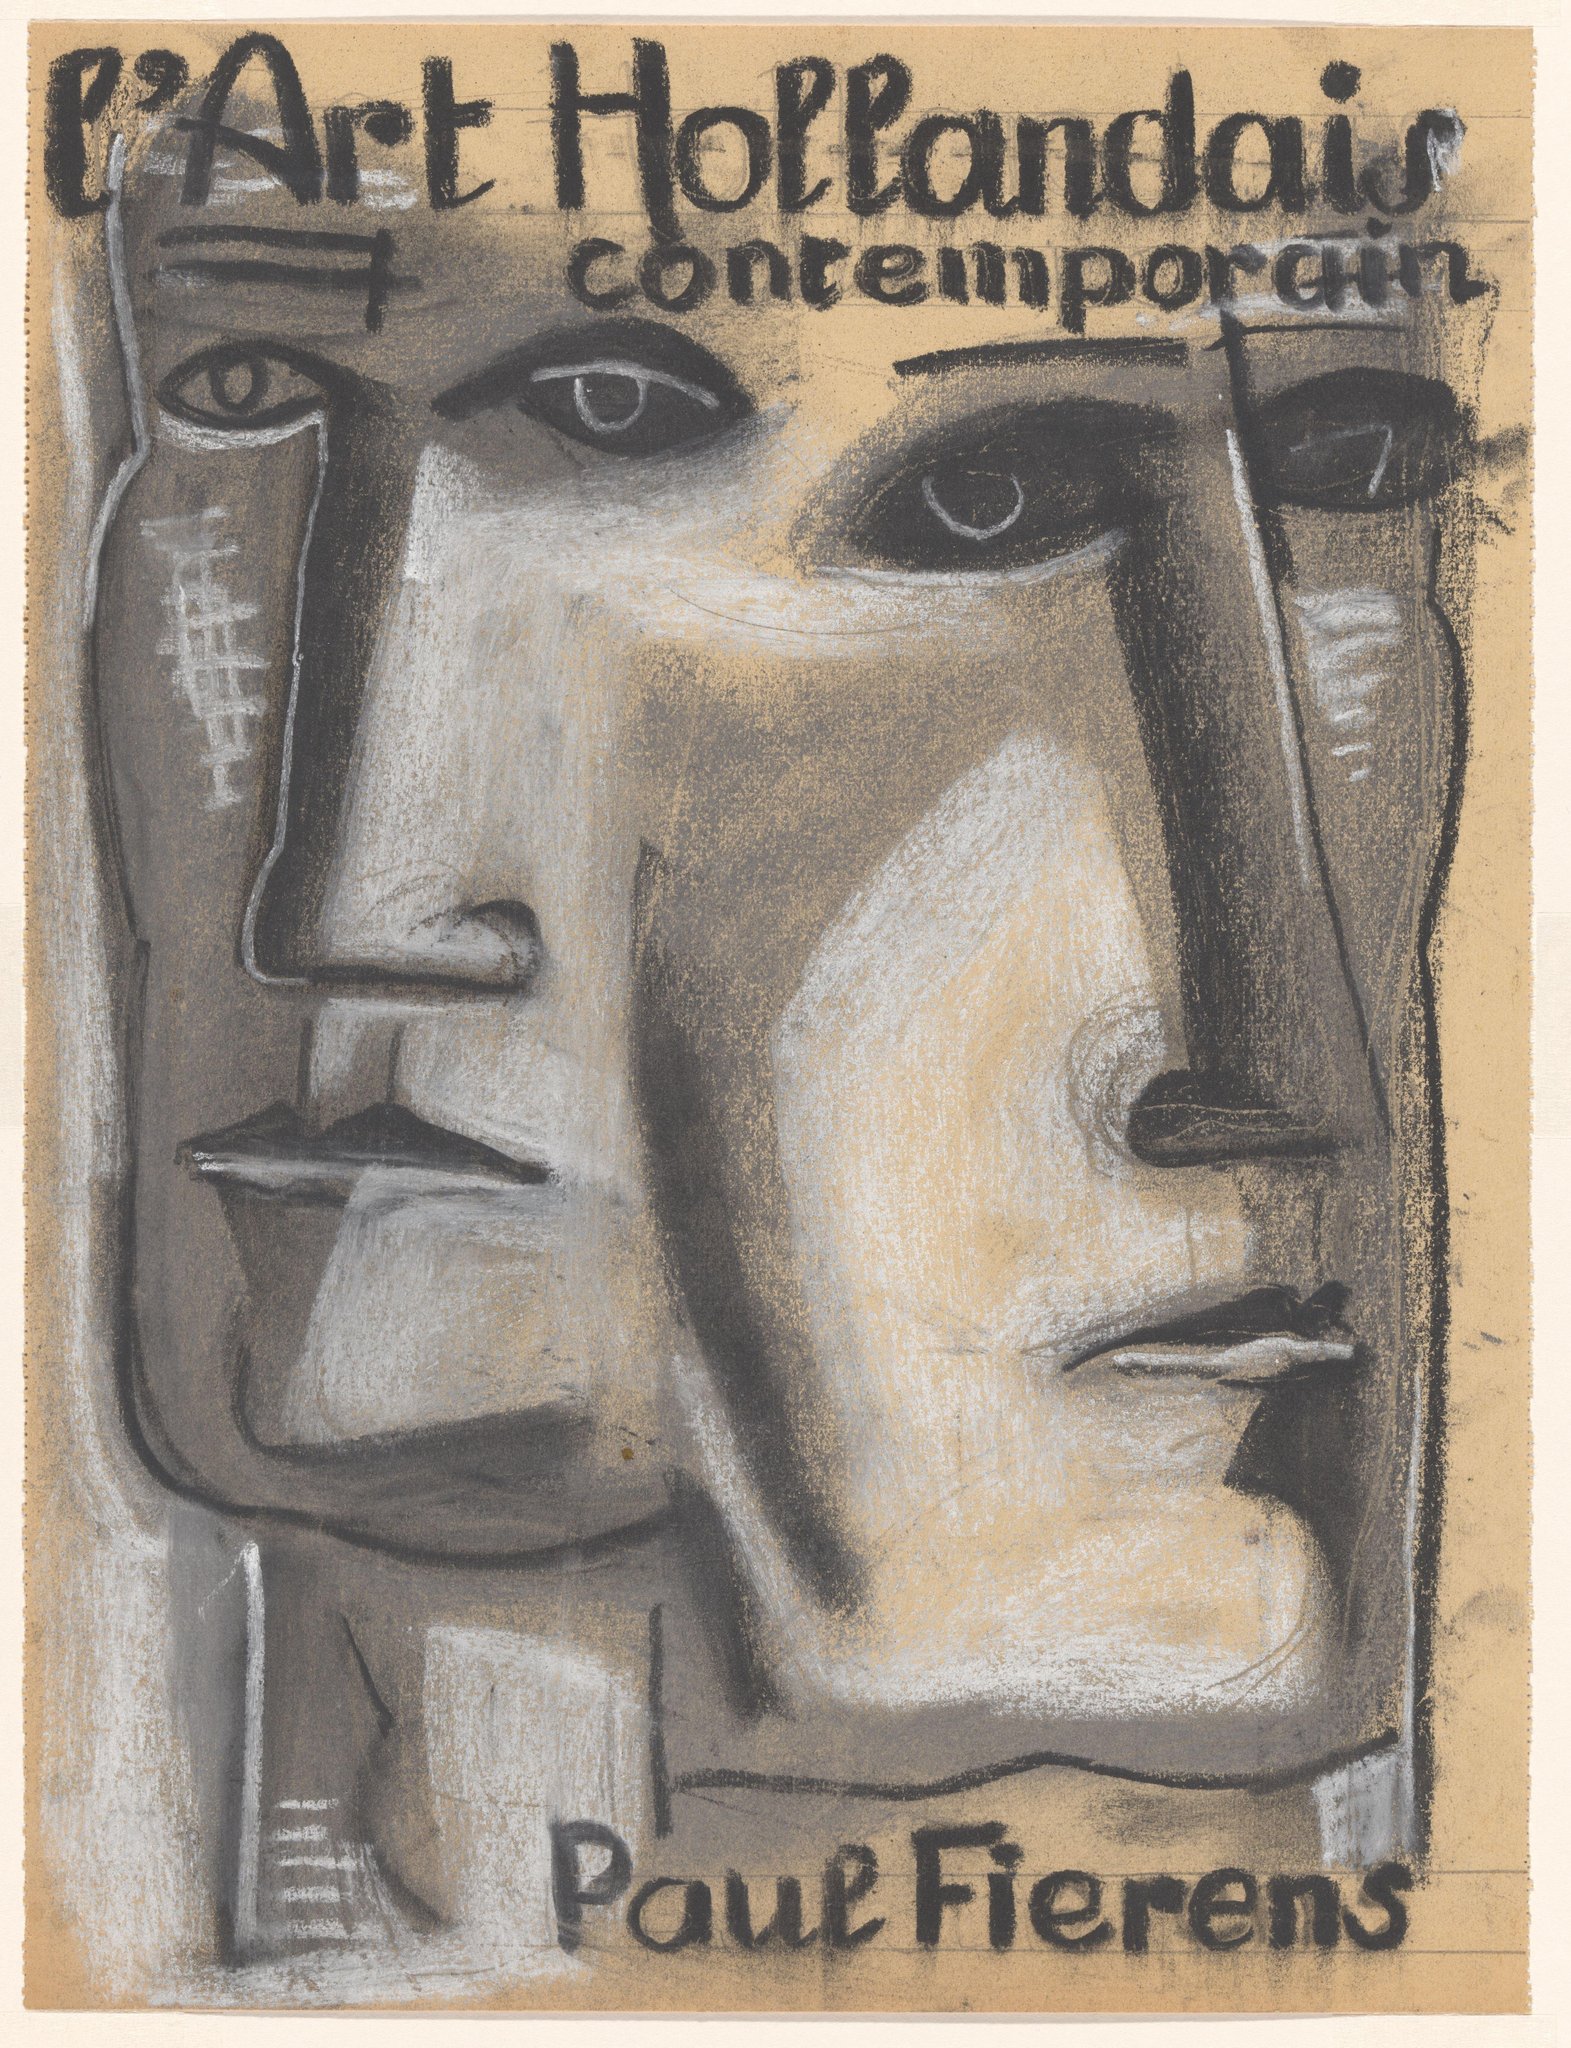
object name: study for binding design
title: Twee gezichten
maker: leo gestel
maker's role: draughtsman, print maker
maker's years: 1881-1941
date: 1933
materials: chalk, paper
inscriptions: inscription: ‘Paul Fierens’, inscription: ‘l'Art Hollandais contemporain’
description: Twee hoekige gezichten in zwart-wit met tekst; ontwerp voor boekomslag Paul Fierens 'L'Art Hollandais contemporain'.